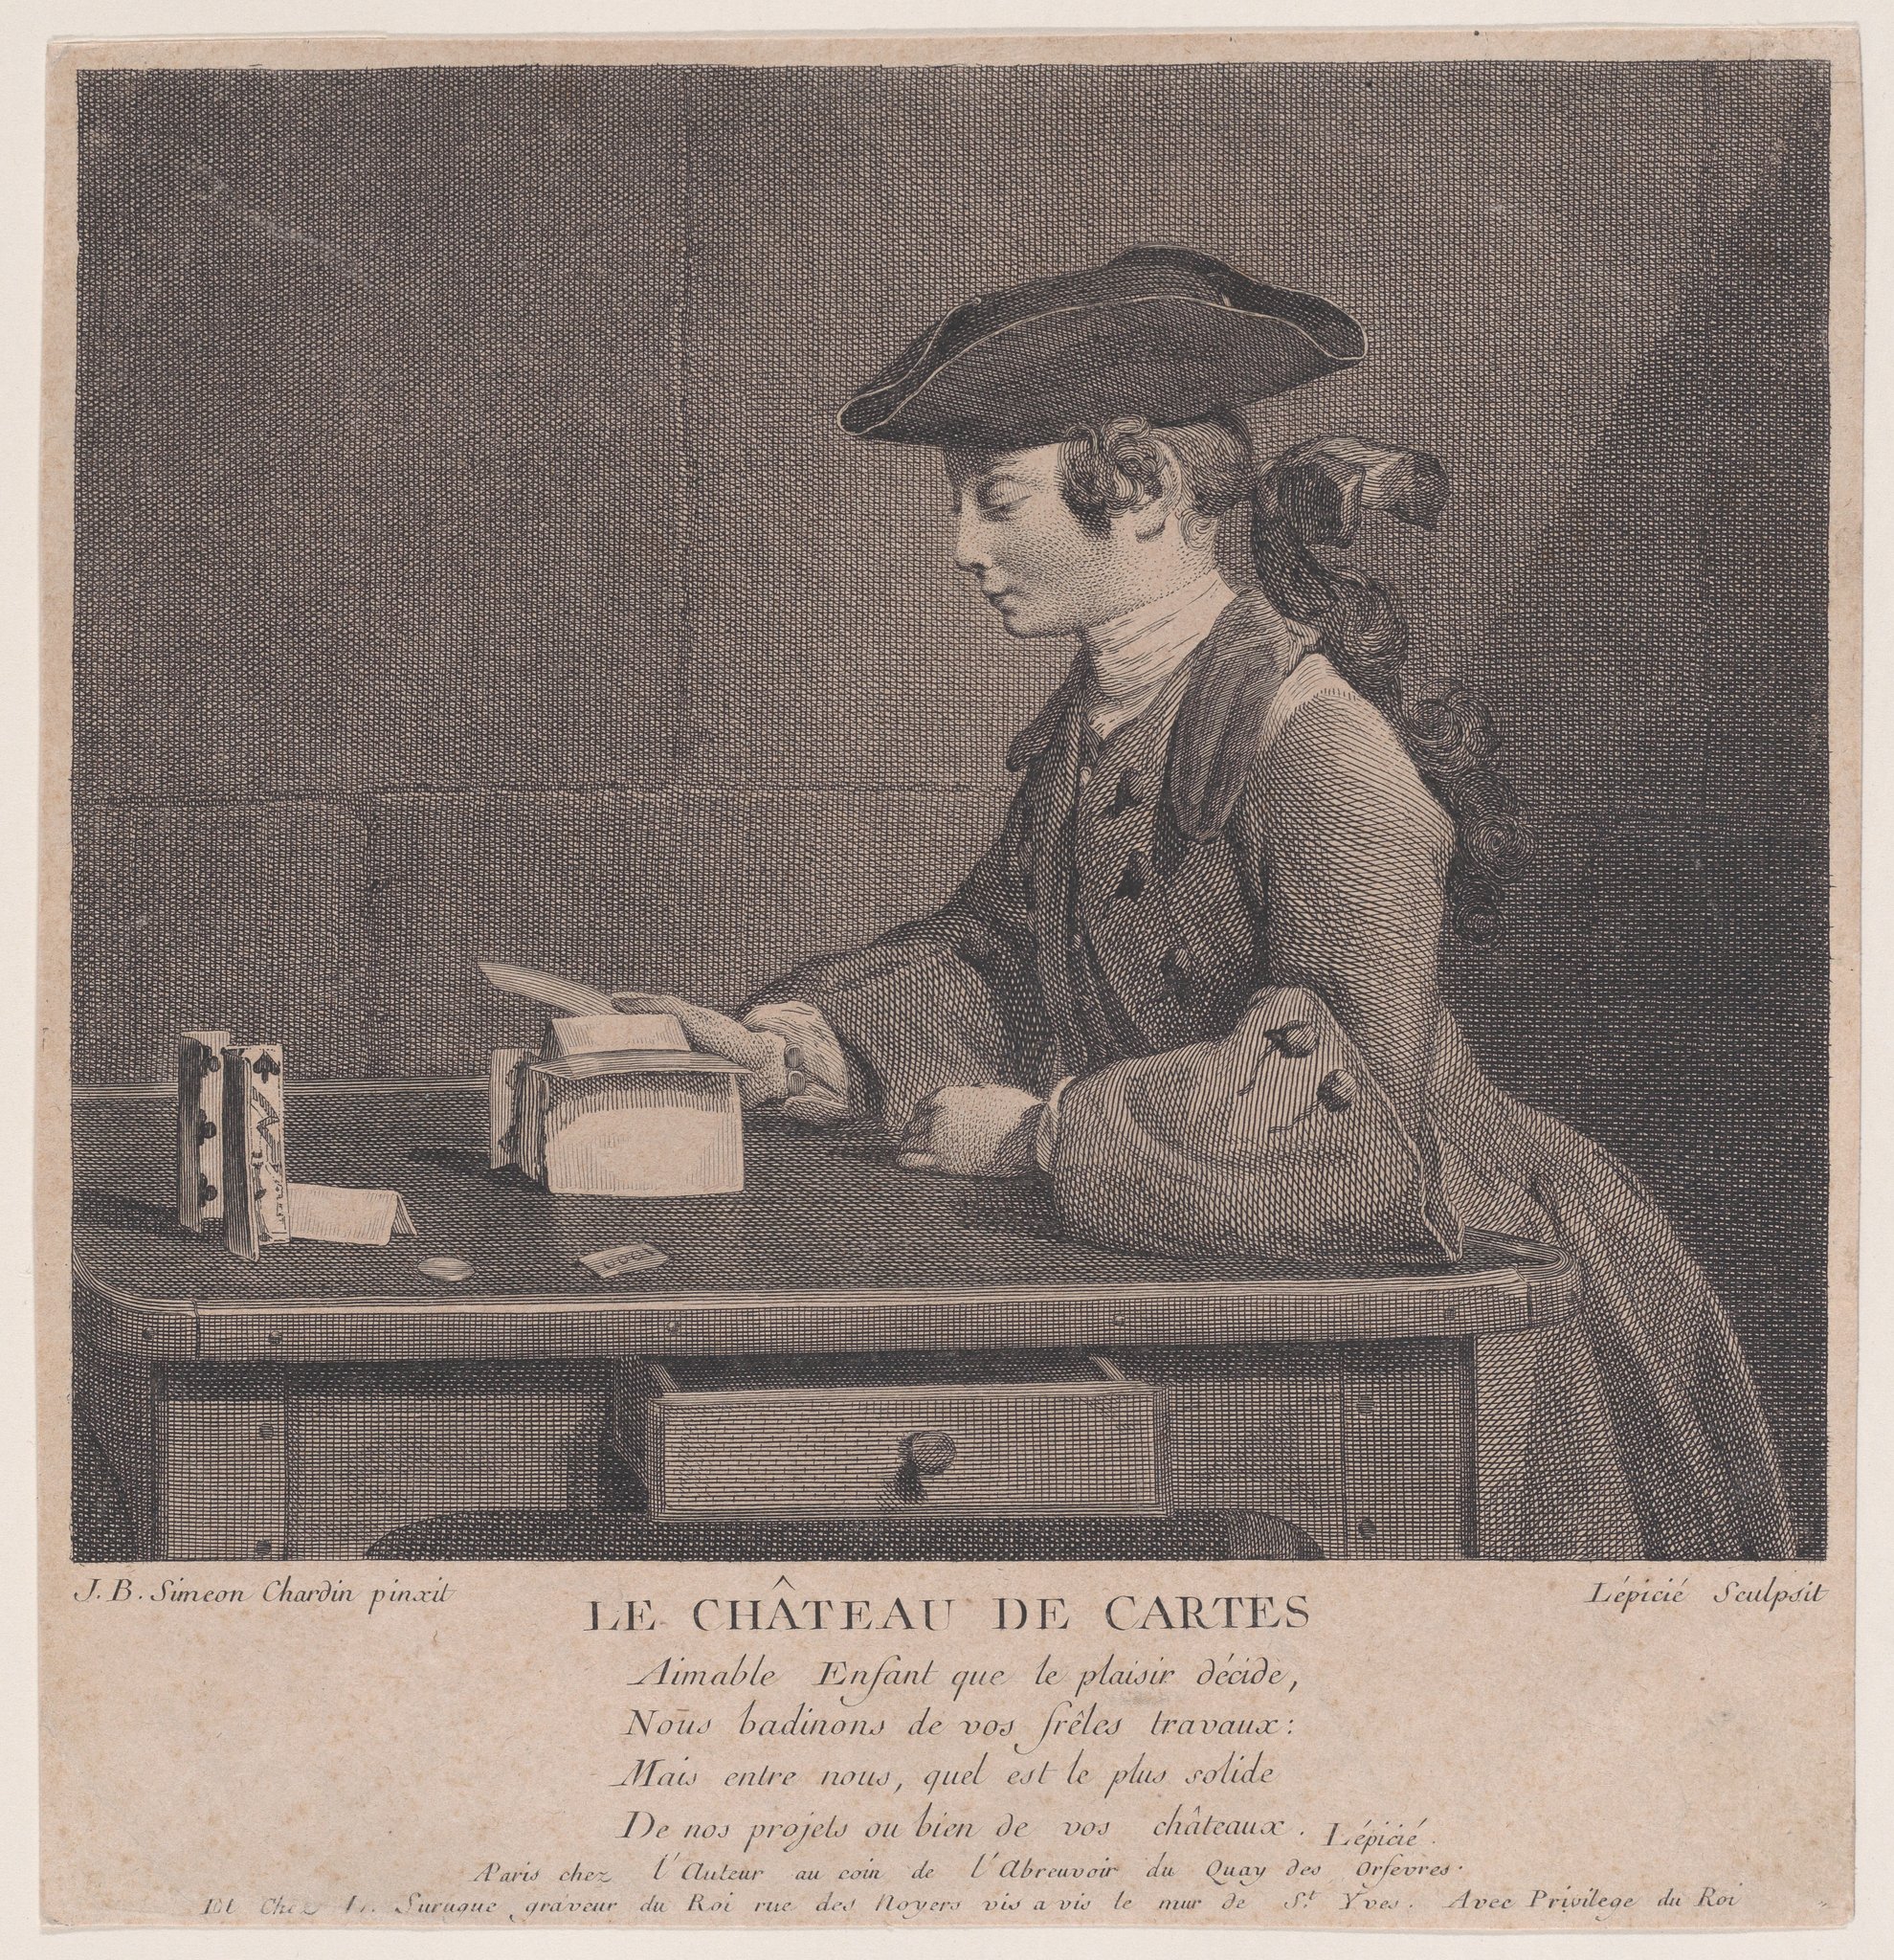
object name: print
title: The Castle of Cards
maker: nicolas bernard lépicié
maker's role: artist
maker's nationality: french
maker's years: 1735-1784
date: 1762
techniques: engraving, etching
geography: paris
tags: boys,playing cards,tables